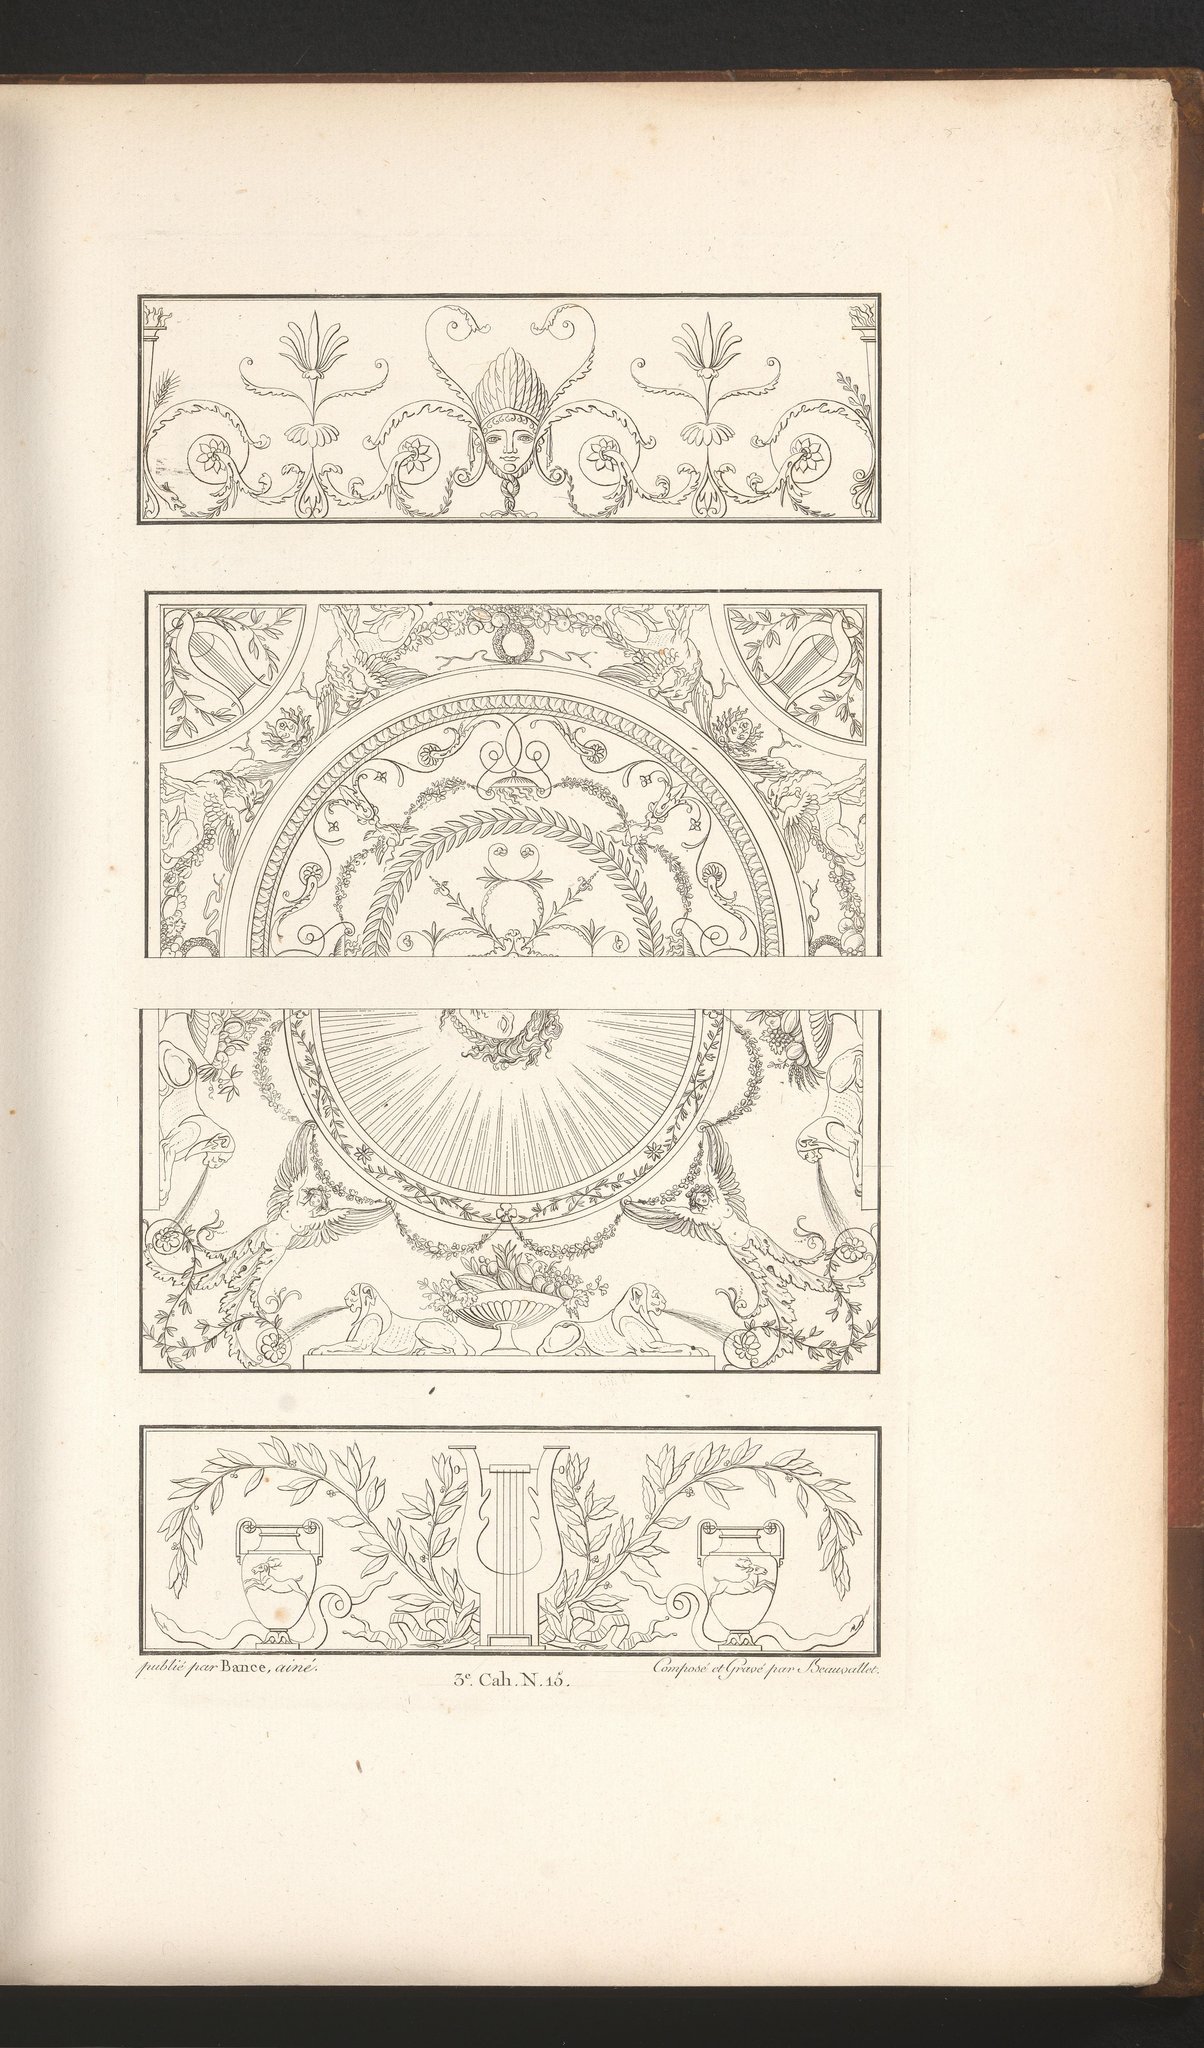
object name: ornament print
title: Plafond- en wandornamenten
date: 1820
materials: paper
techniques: etching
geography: paris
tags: ornaments ~ art, (decorated) ceiling, wall-covering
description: Ornamentprent met plafond- en wandornamenten. Onderdeel van het prentalbum met twee series van in totaal 138 ornamentprenten door Beauvallet en Normand, 'Fragmens d'Ornemens dans le Style Antique'.